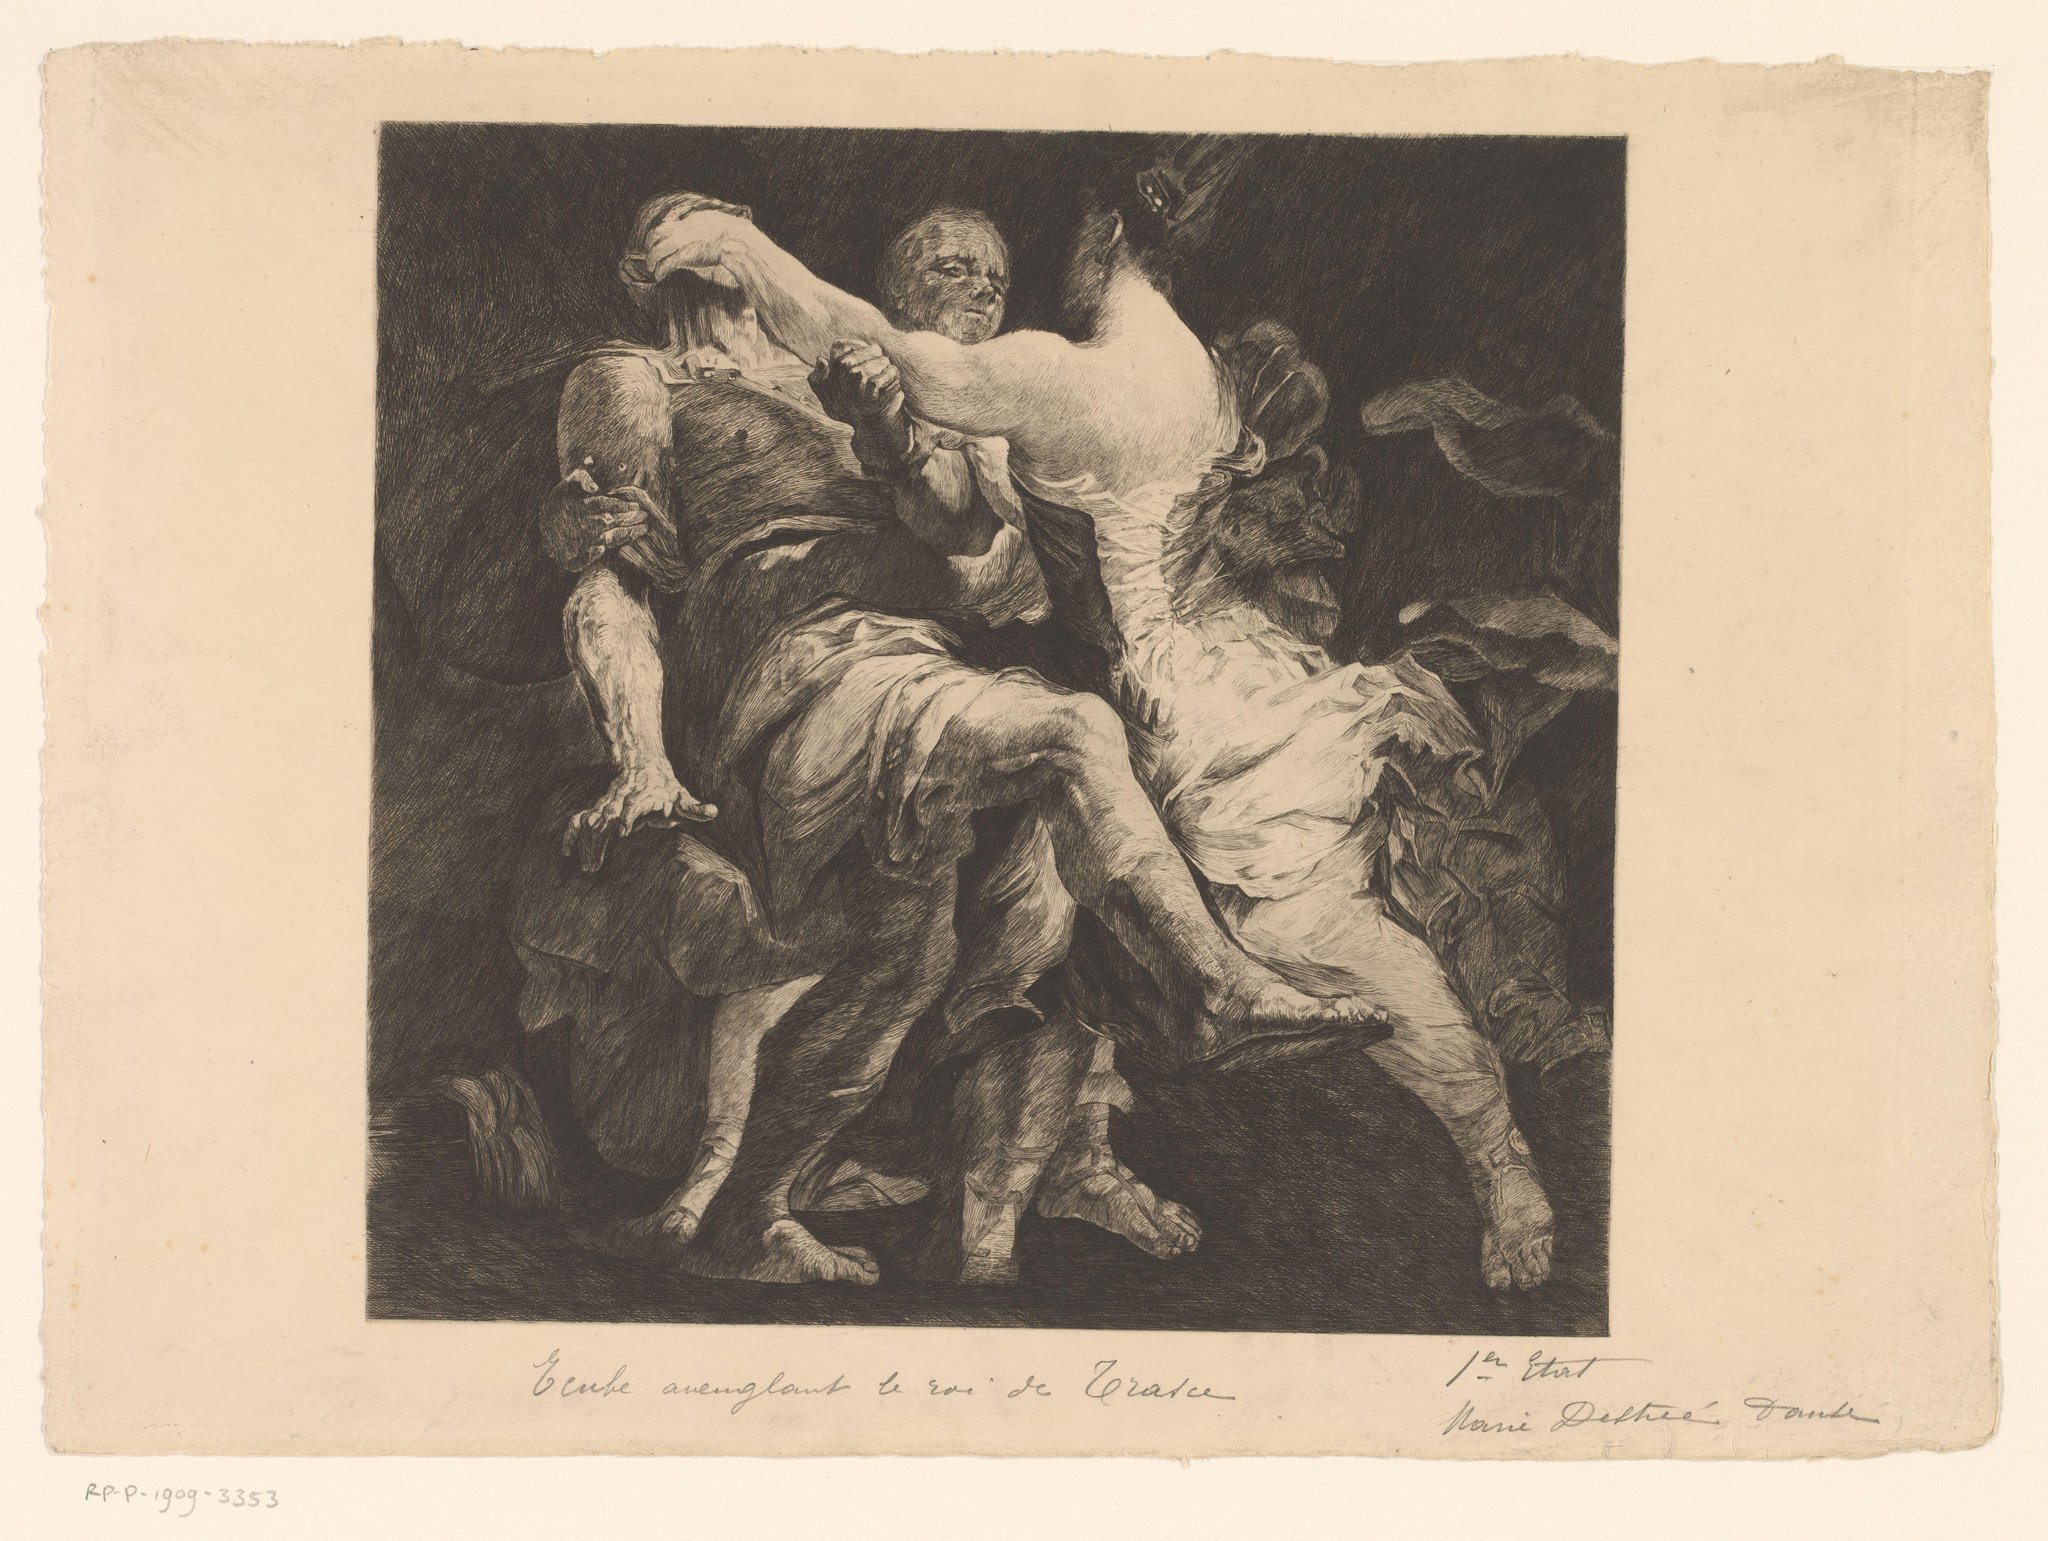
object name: print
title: Hekabe maakt Polymestor blind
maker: marie danse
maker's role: print maker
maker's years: 1867-1942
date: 1877-1909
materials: paper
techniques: etching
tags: hecuba tears out polymnestor's eyes and kills his two sons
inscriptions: collector's mark: Lugt 2228, inscription: ‘[Hecube avenglant le soi de gratce] 1em Etat’